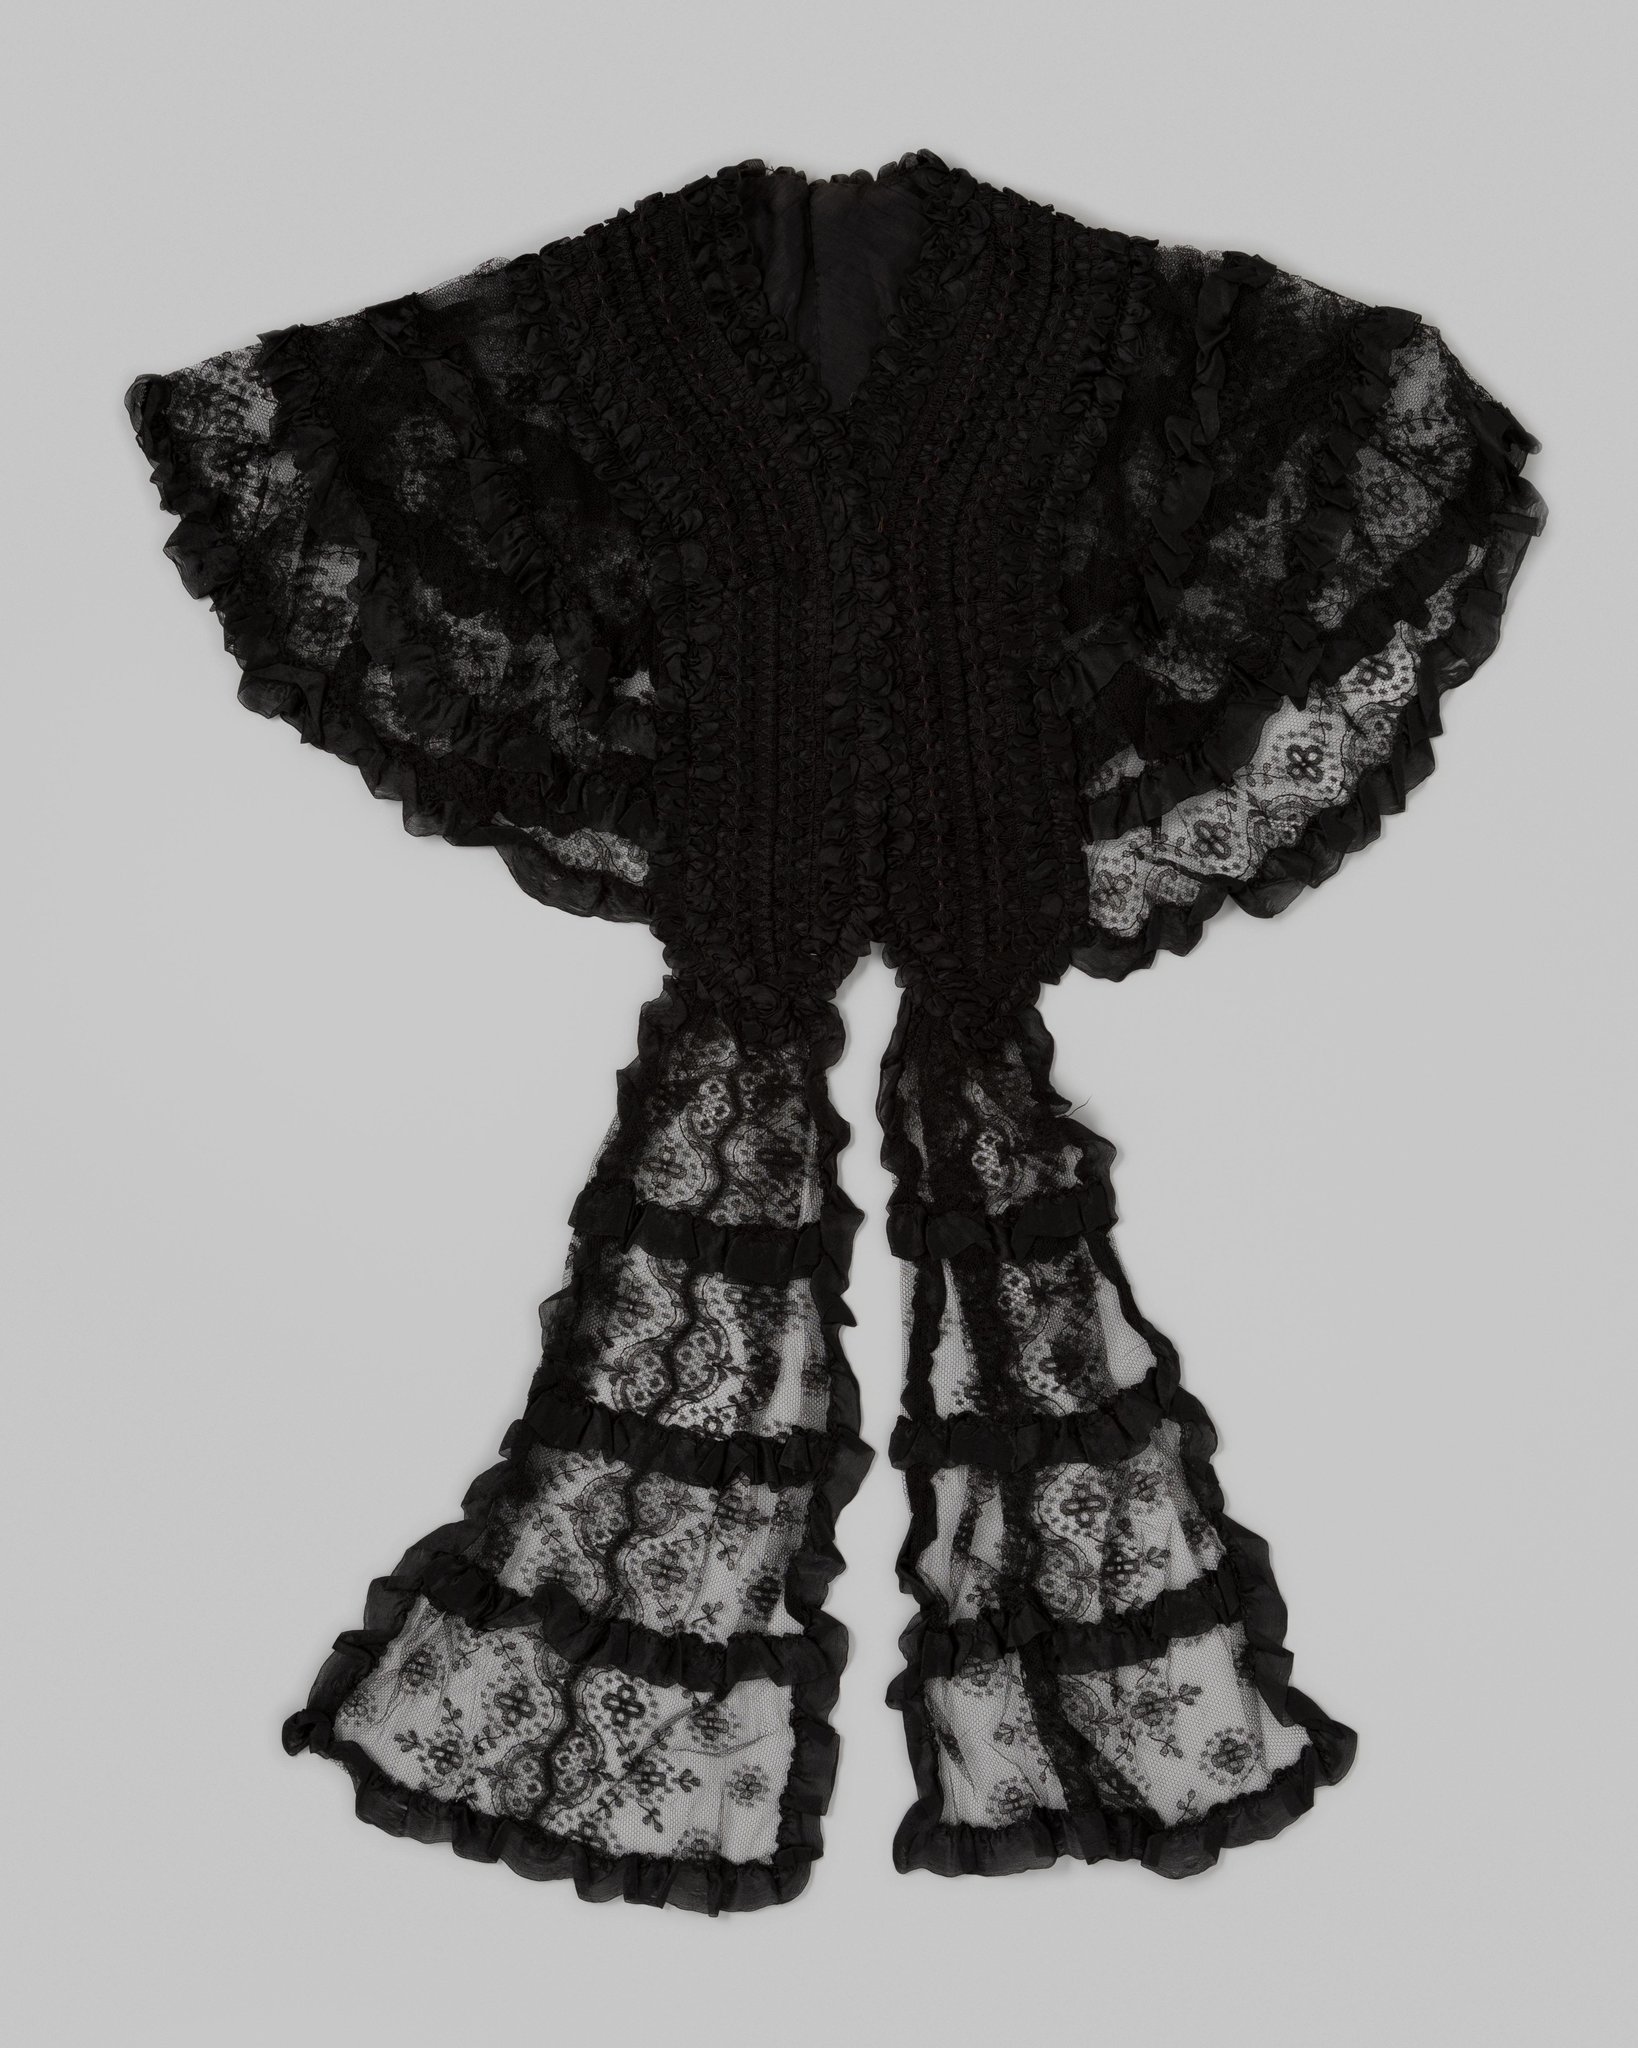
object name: cape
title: Pelerine (schoudermantel) met slippen, van machinale Chantillykant versierd met lint en passement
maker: Anonymous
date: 1855-1860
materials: lace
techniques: lace, weave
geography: france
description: Pelerine (schoudermantel) met slippen, van machinale Chantilly versierd met lint en passement. Model: rond schoudermodel van twee stroken kant, versierd met drie rijtjes lint. Een gladde omslag sluit tegen nek en hals aan en hangt aan de voorzijde in twee rechte delen neer. Deze pas, die belegd is met zwarte passement en gefronst lint, heeft puntige uiteinden, waaronder twee rechte, van langs de schulpen aaneengezette kanten samengestelde, slippen komen, ook voorzien van lintstrookjes. Techniek: de geschulpte kant is een machinale namaak van Chantilly. Kantpatroon: gestrooide vierpasvormige bloempjes en nopjes. De schulpen zijn versierd met voluten en palmetjes.